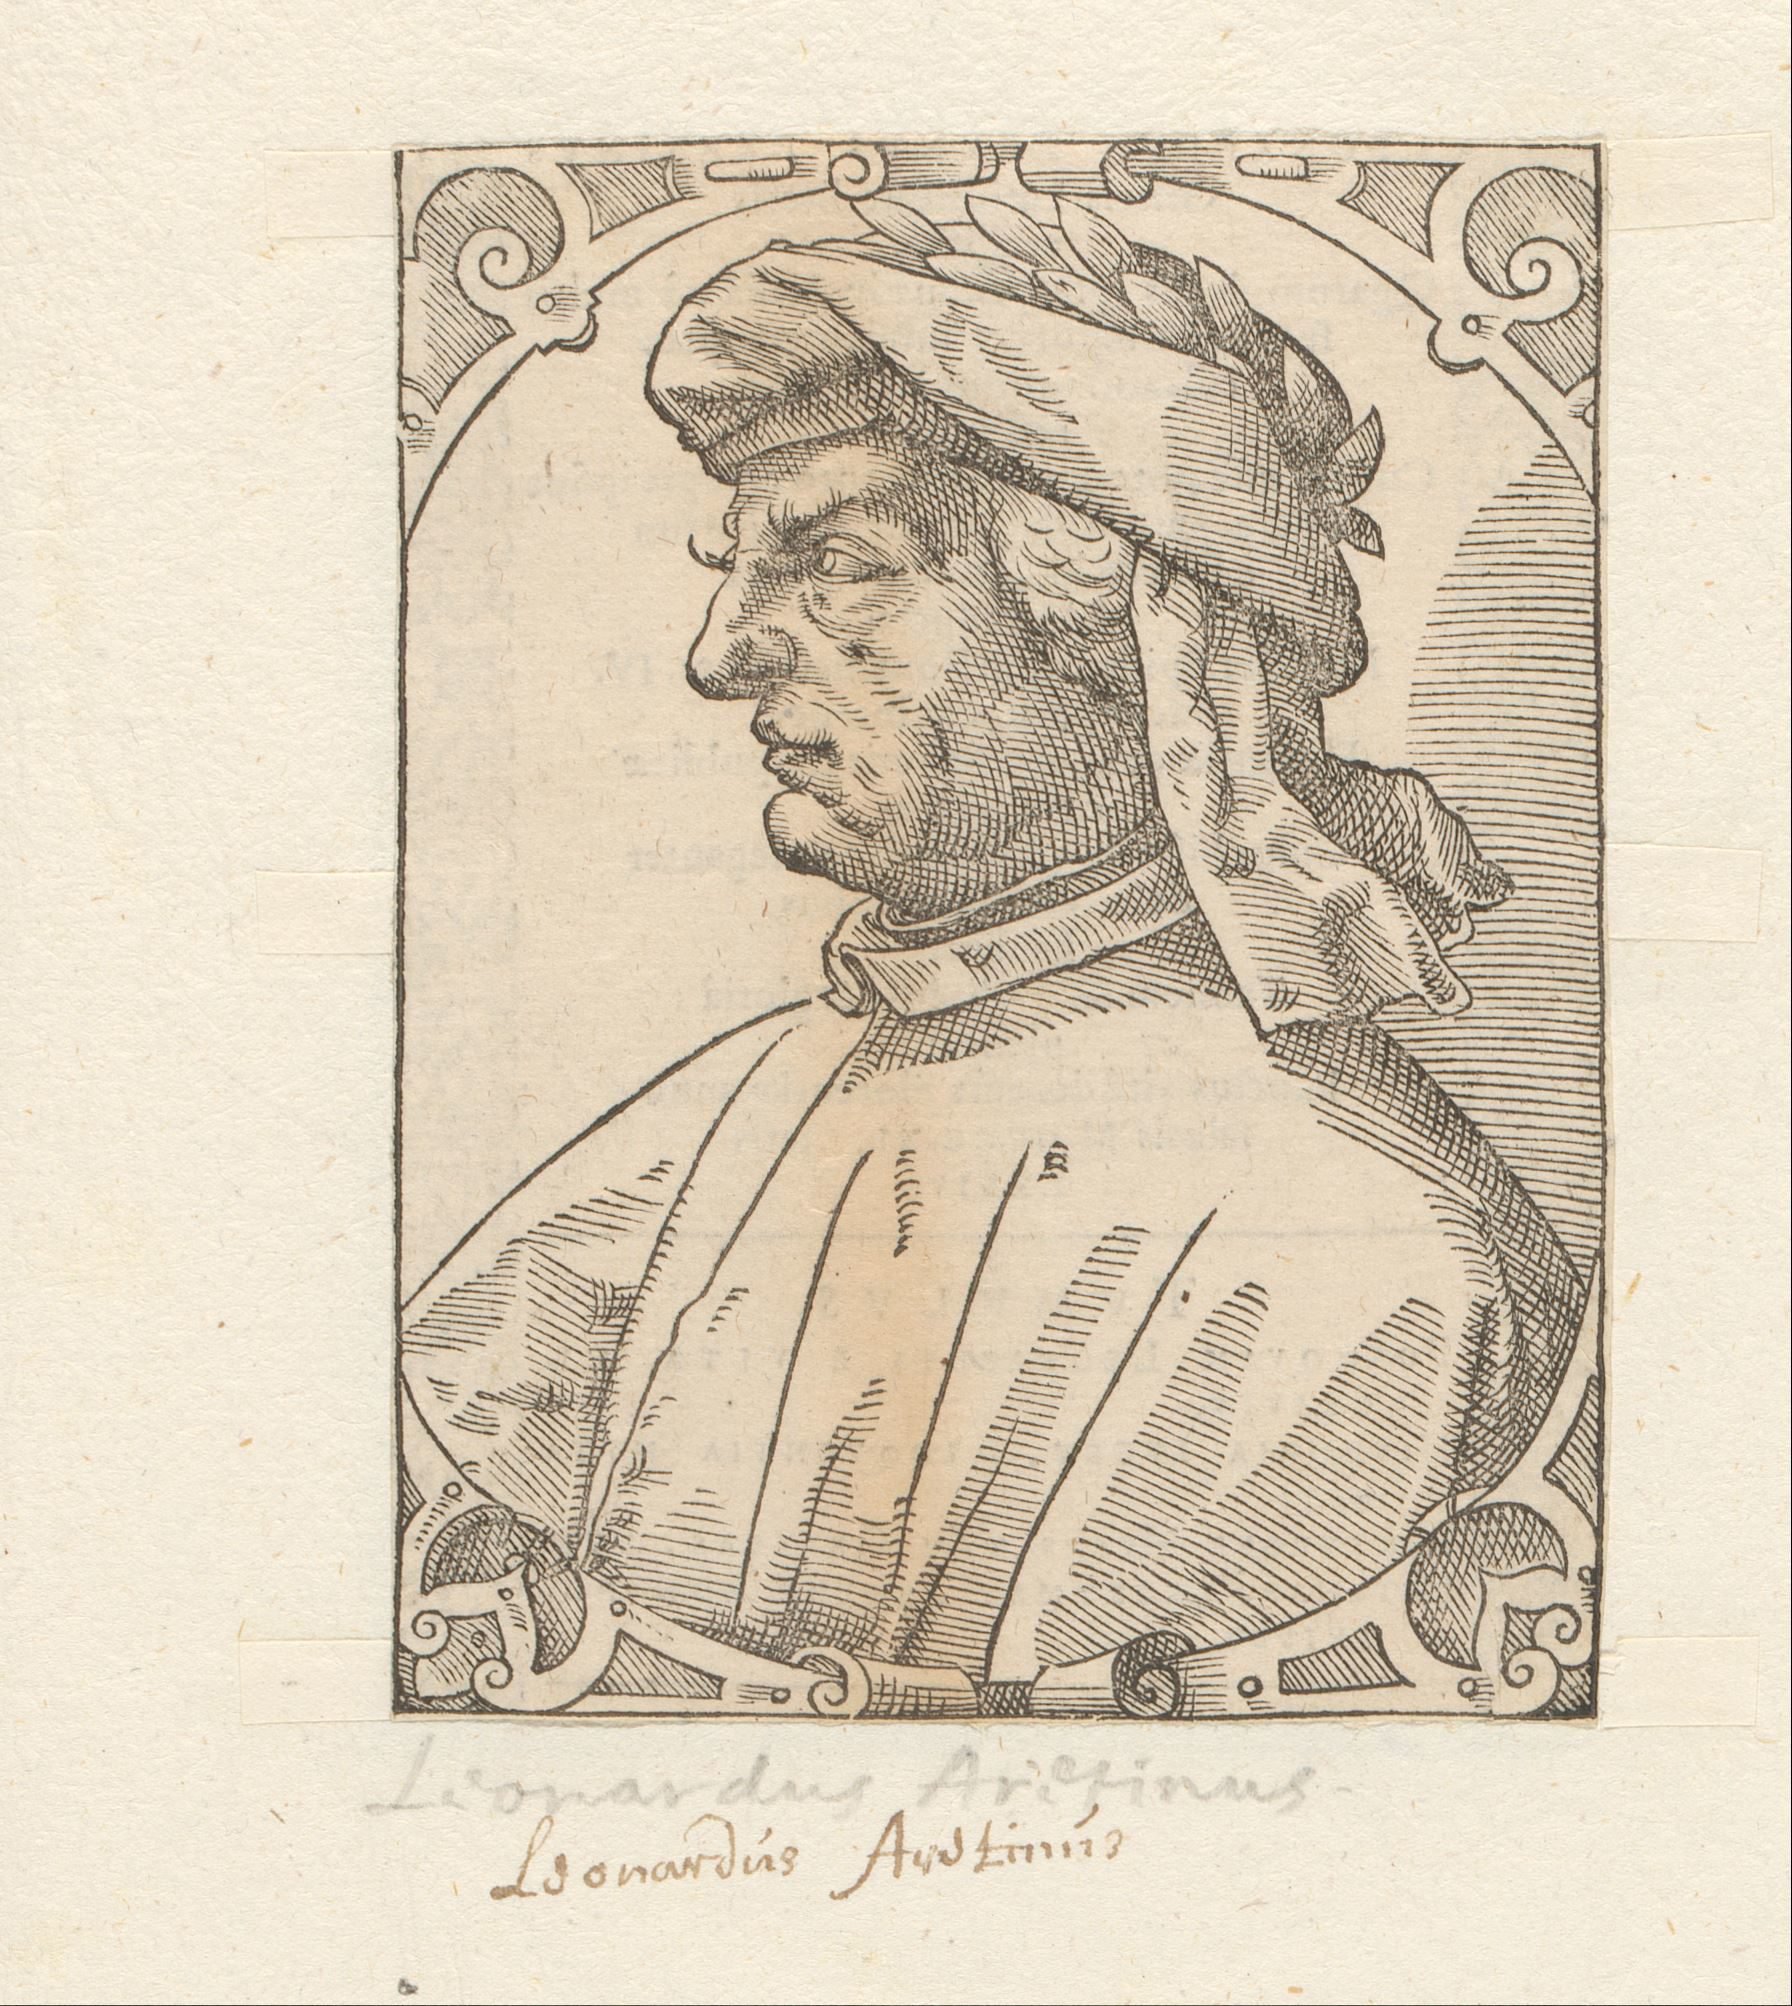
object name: album leaf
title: Portret van Leonardo Bruni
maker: Anonymous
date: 1549-1577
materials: paper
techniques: letterpress printing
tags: historical persons, portrait of a writer, scholar, philosopher (+ portrait of scholar, scientist)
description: Prent gebruikt in: Giovio, Paolo. Elogia Virorum literis illustrium (...). Bazel: Peter Perna, 1577.